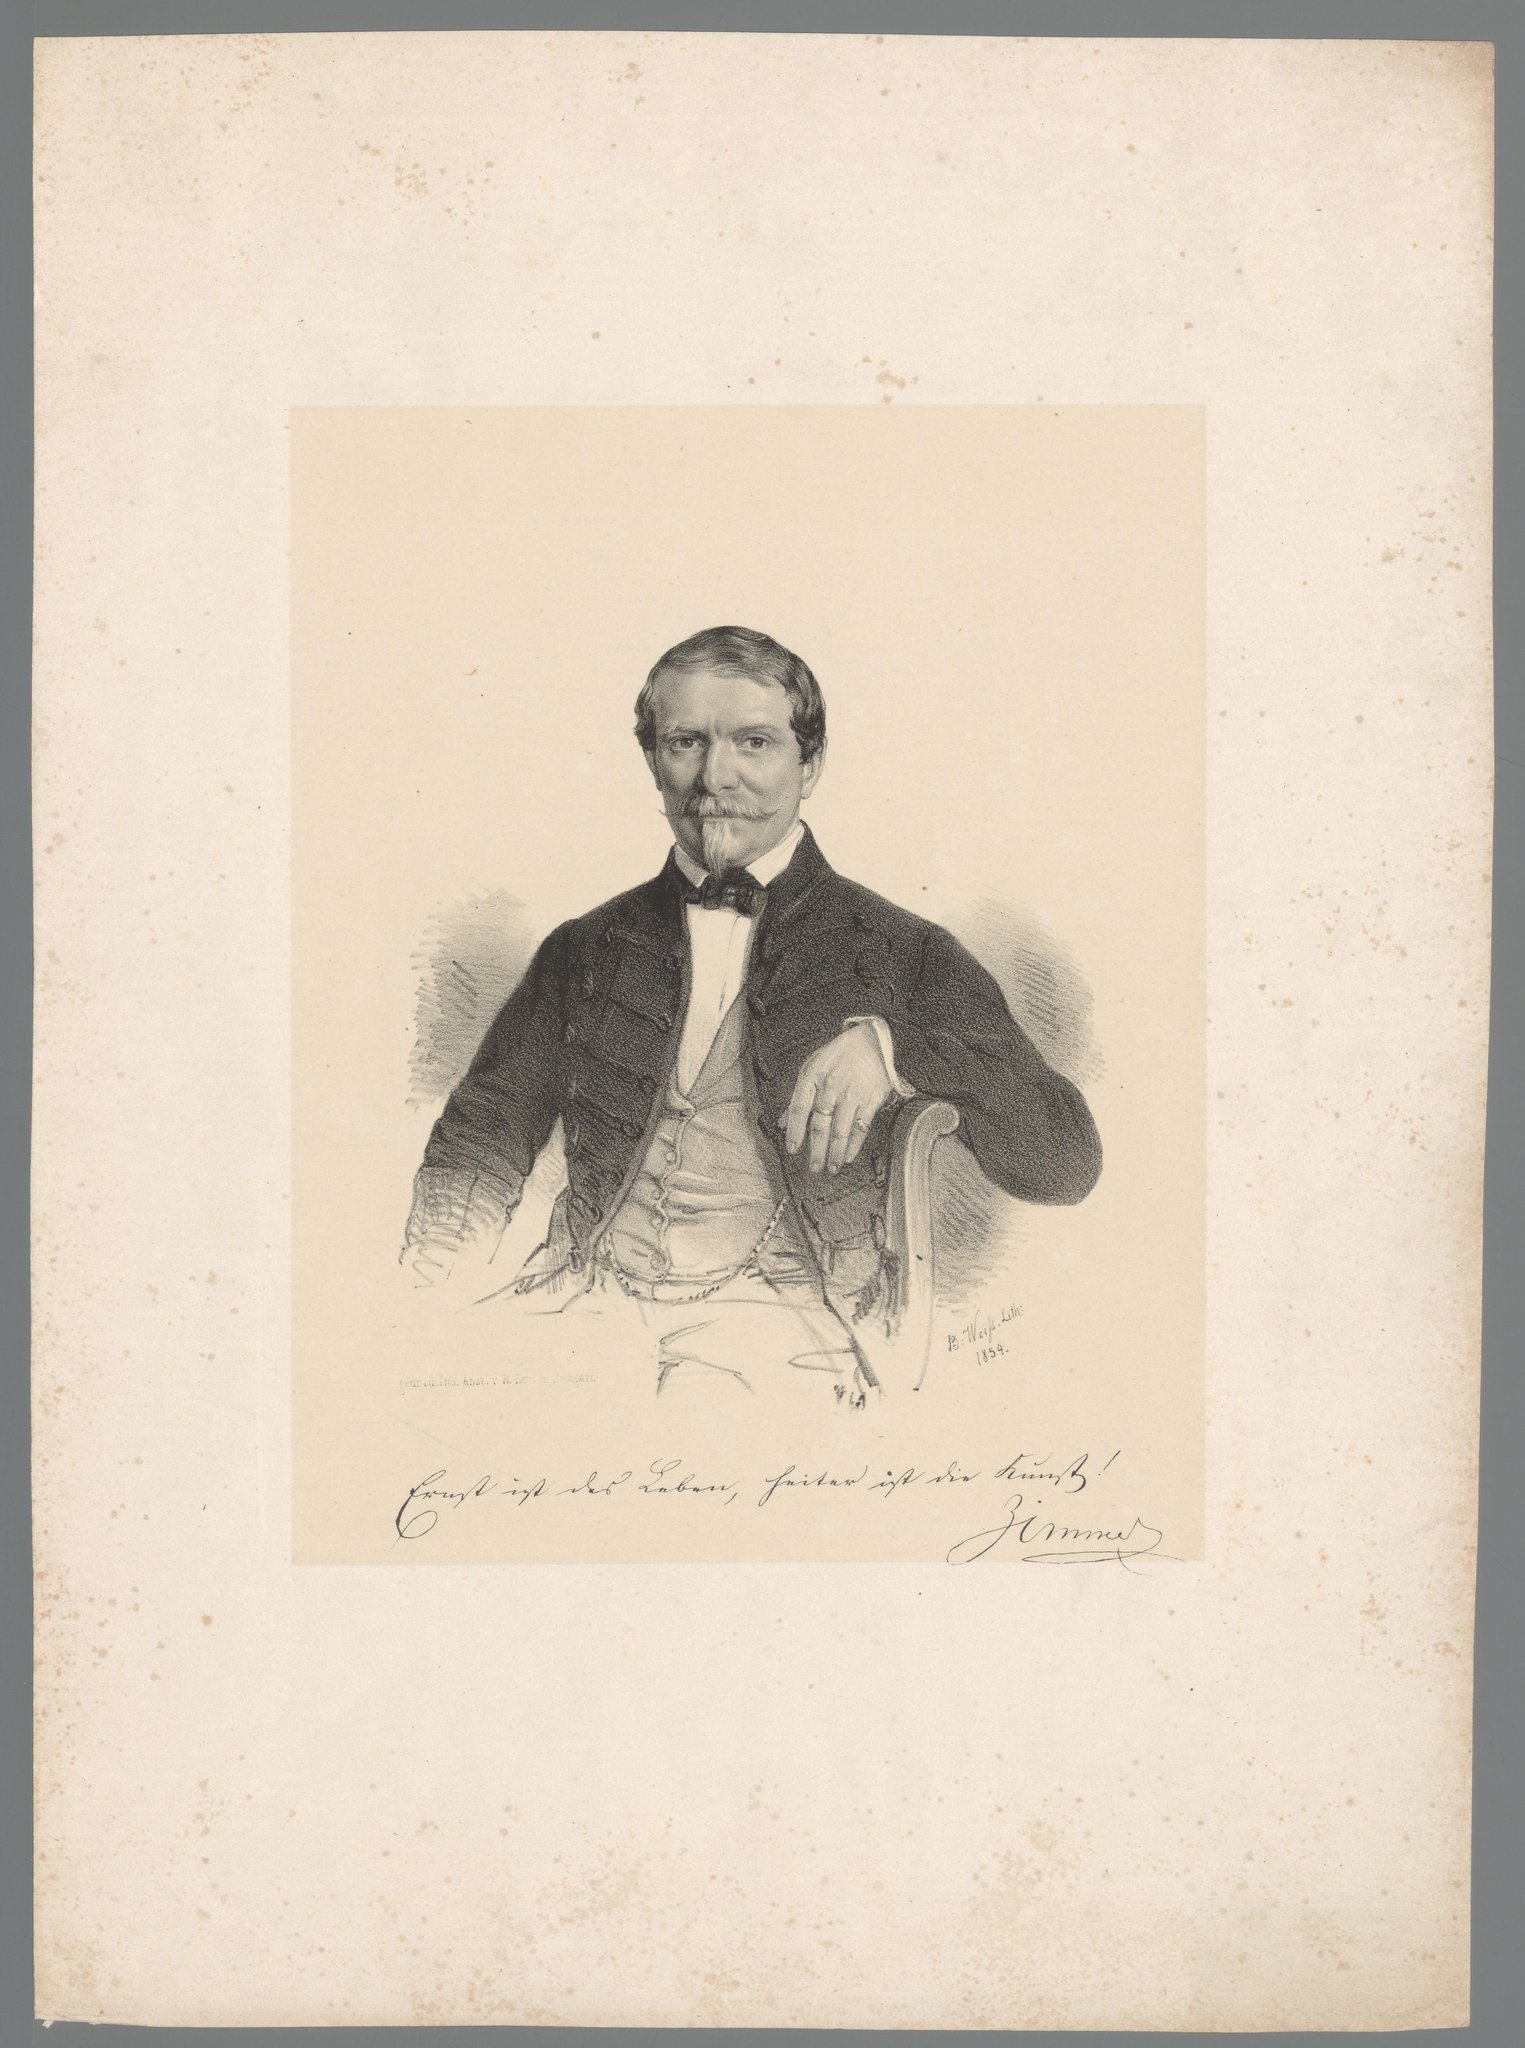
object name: print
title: Portret van een onbekende man, mogelijk Zimmer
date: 1854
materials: paper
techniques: lithograph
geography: stuttgart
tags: adult man, historical persons, beard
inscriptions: collector's mark: Lugt 2228